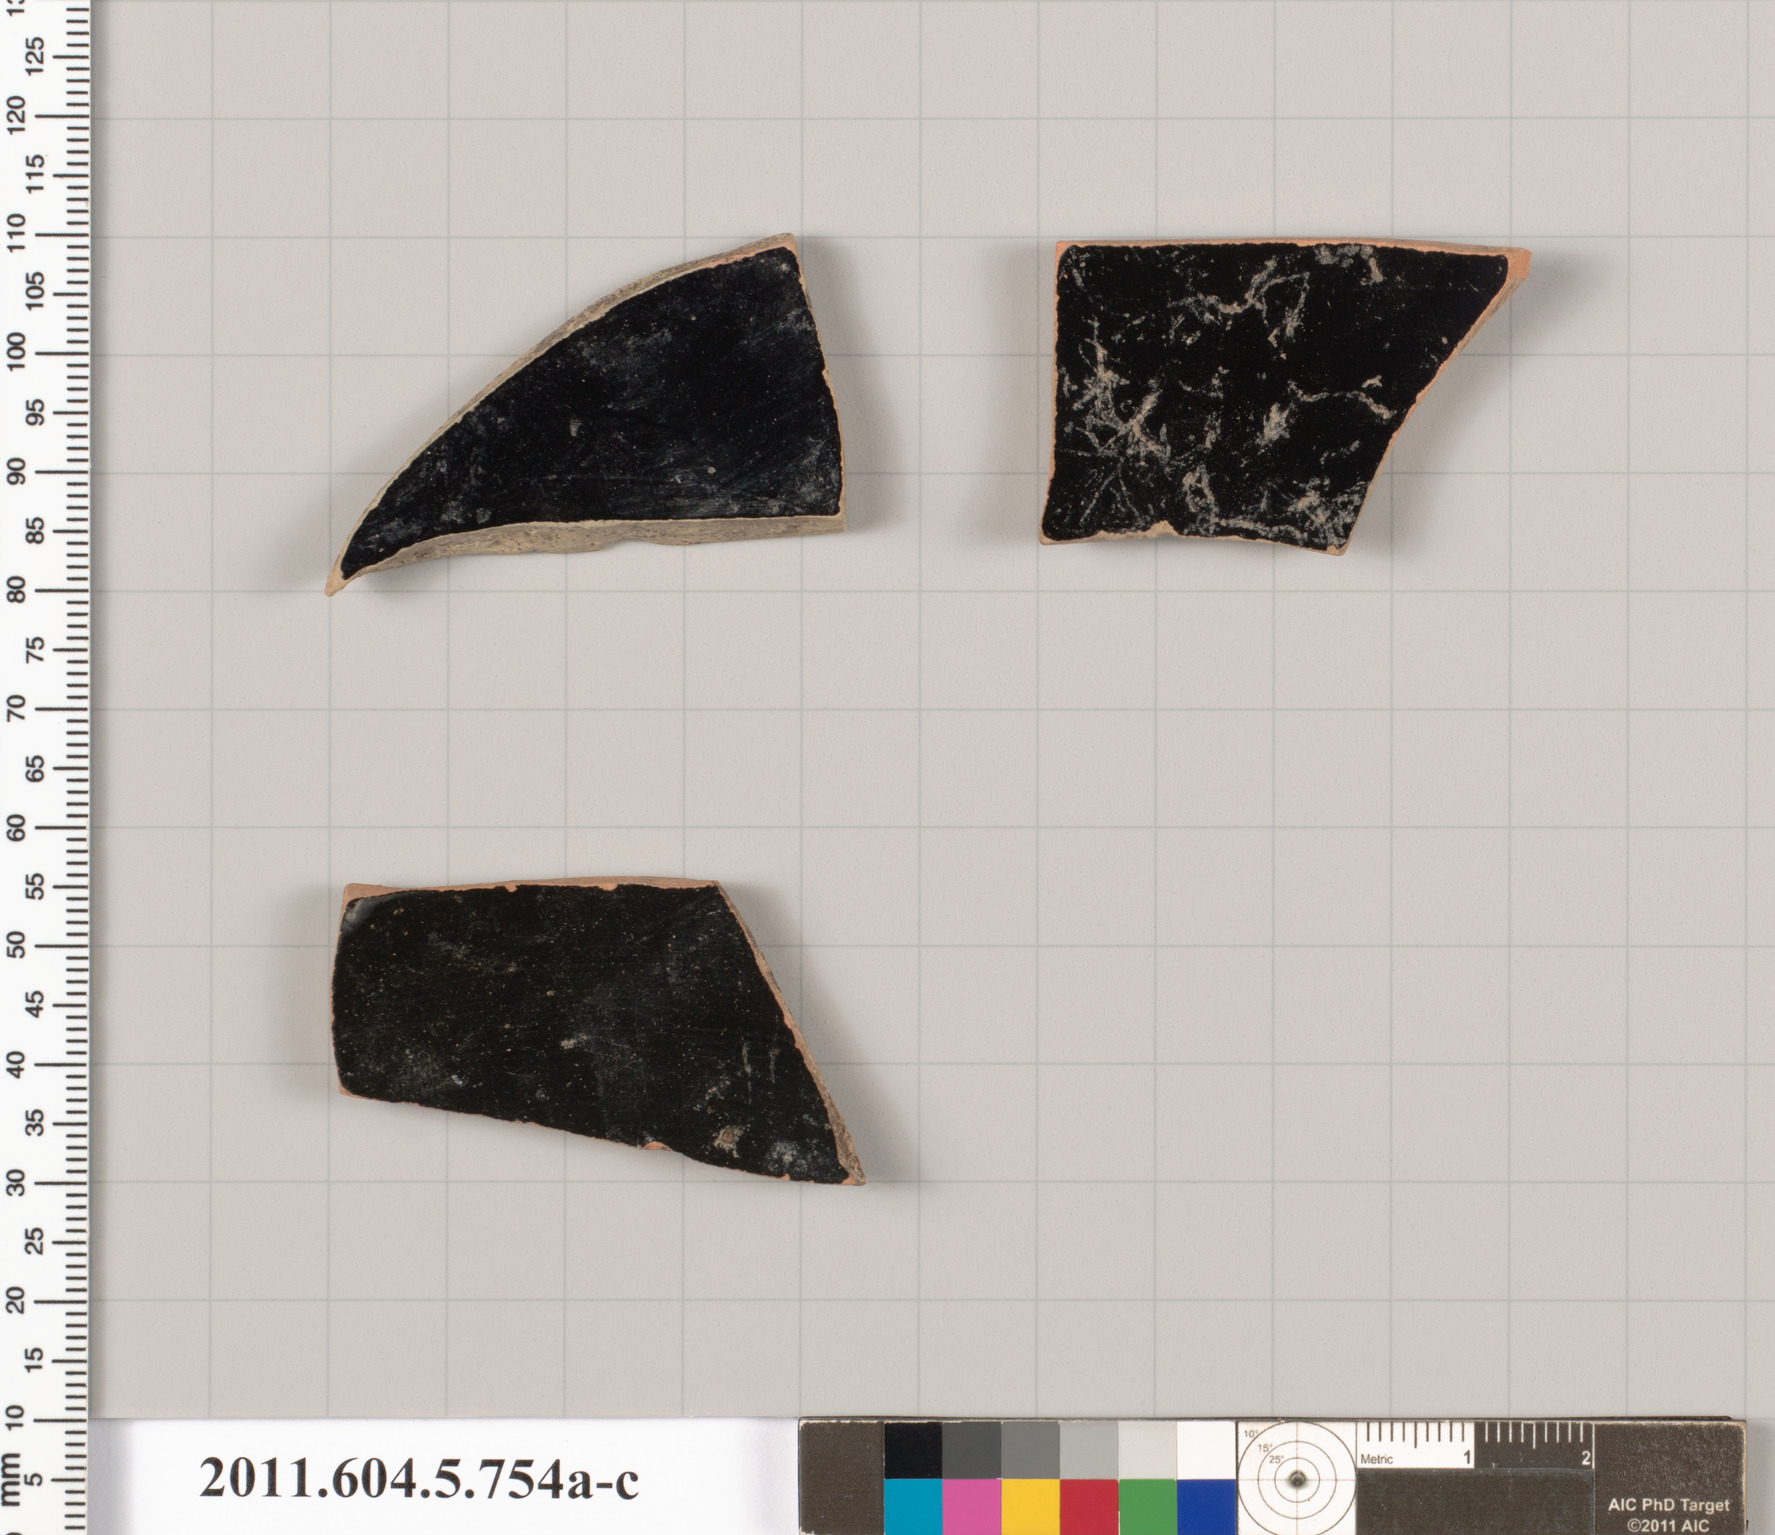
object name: kylix fragment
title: Terracotta fragments of kylikes (drinking cups)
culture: greek, attic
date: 600-401 BCE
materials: terracotta